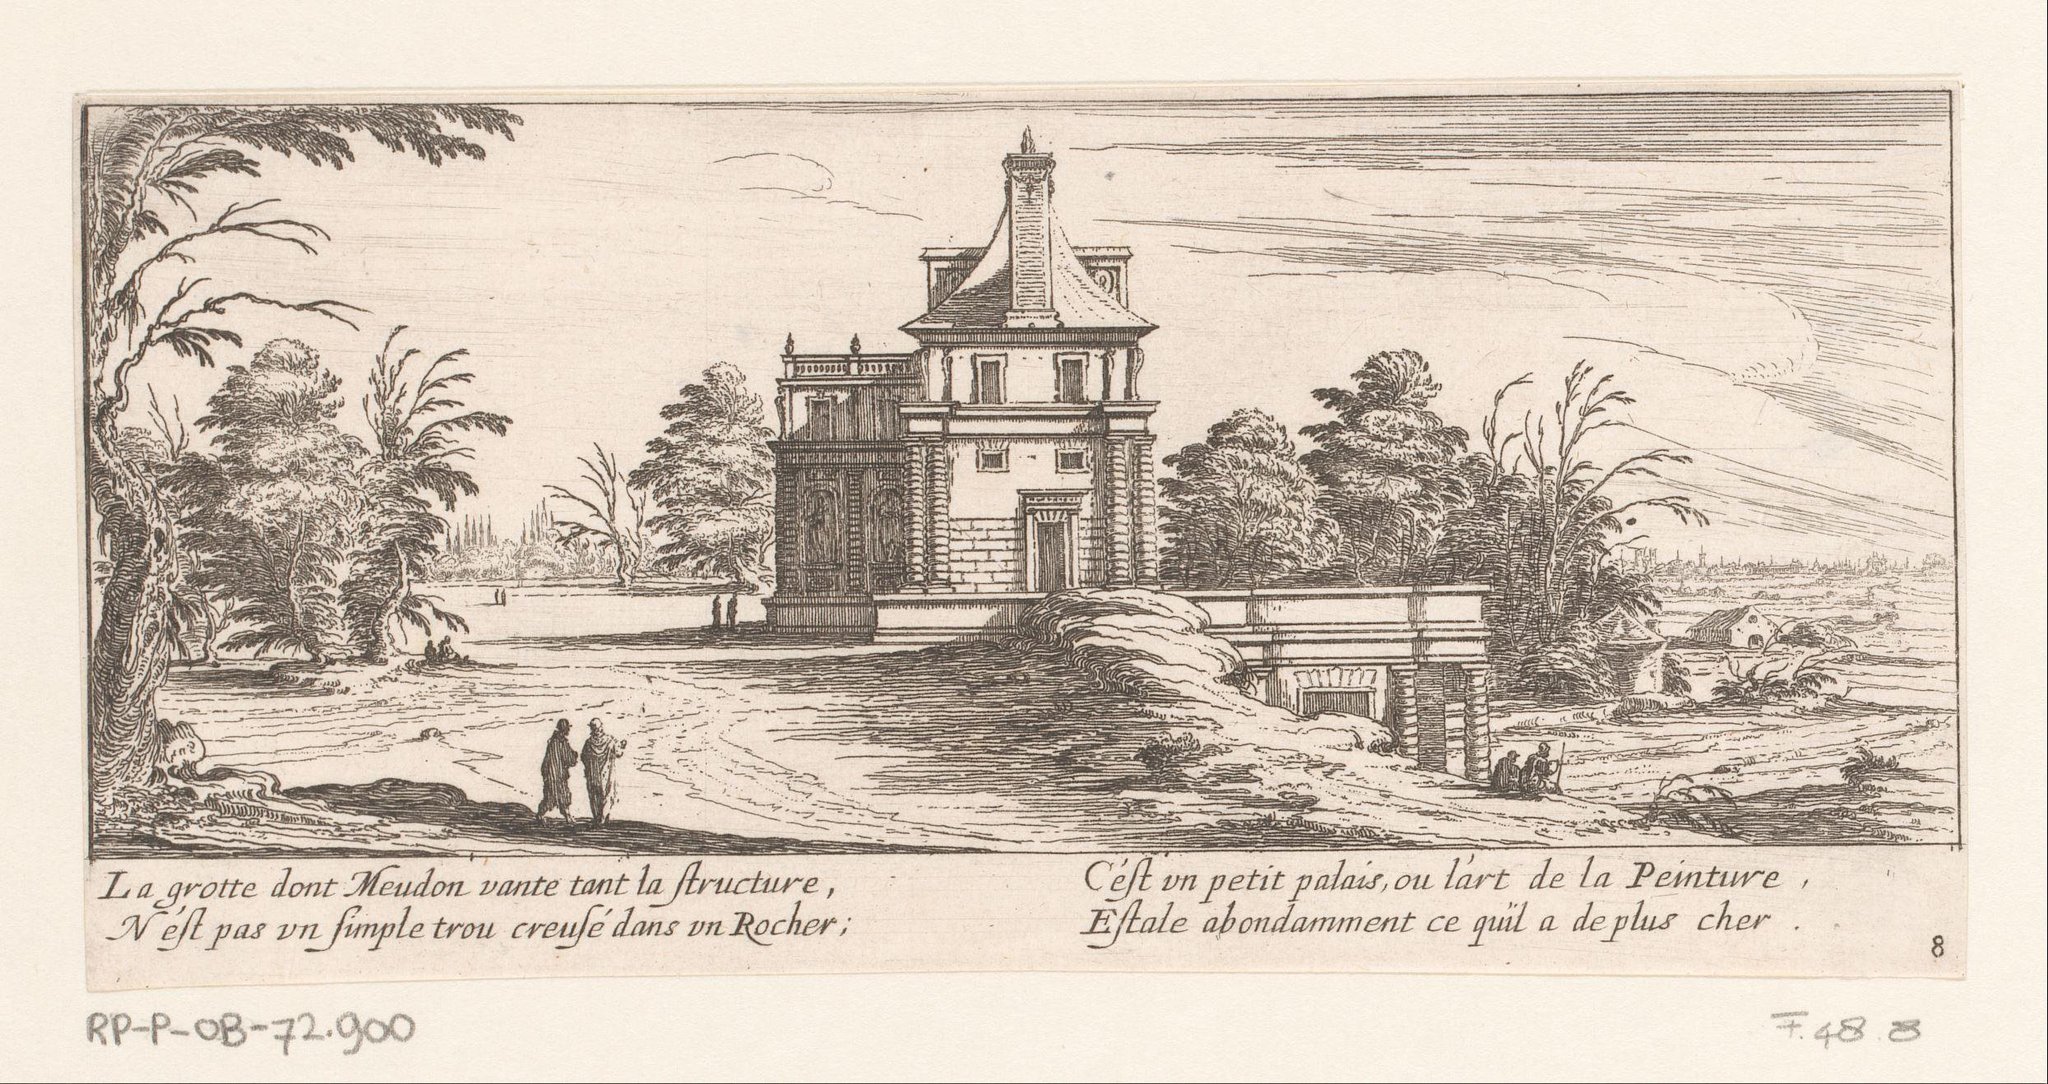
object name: print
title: De meest opmerkelijke plaatsen in Parijs en omgeving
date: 1655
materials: paper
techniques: etching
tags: city-view, and landscape with man-made constructions, artificial grotto in garden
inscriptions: collector's mark: Lugt 240